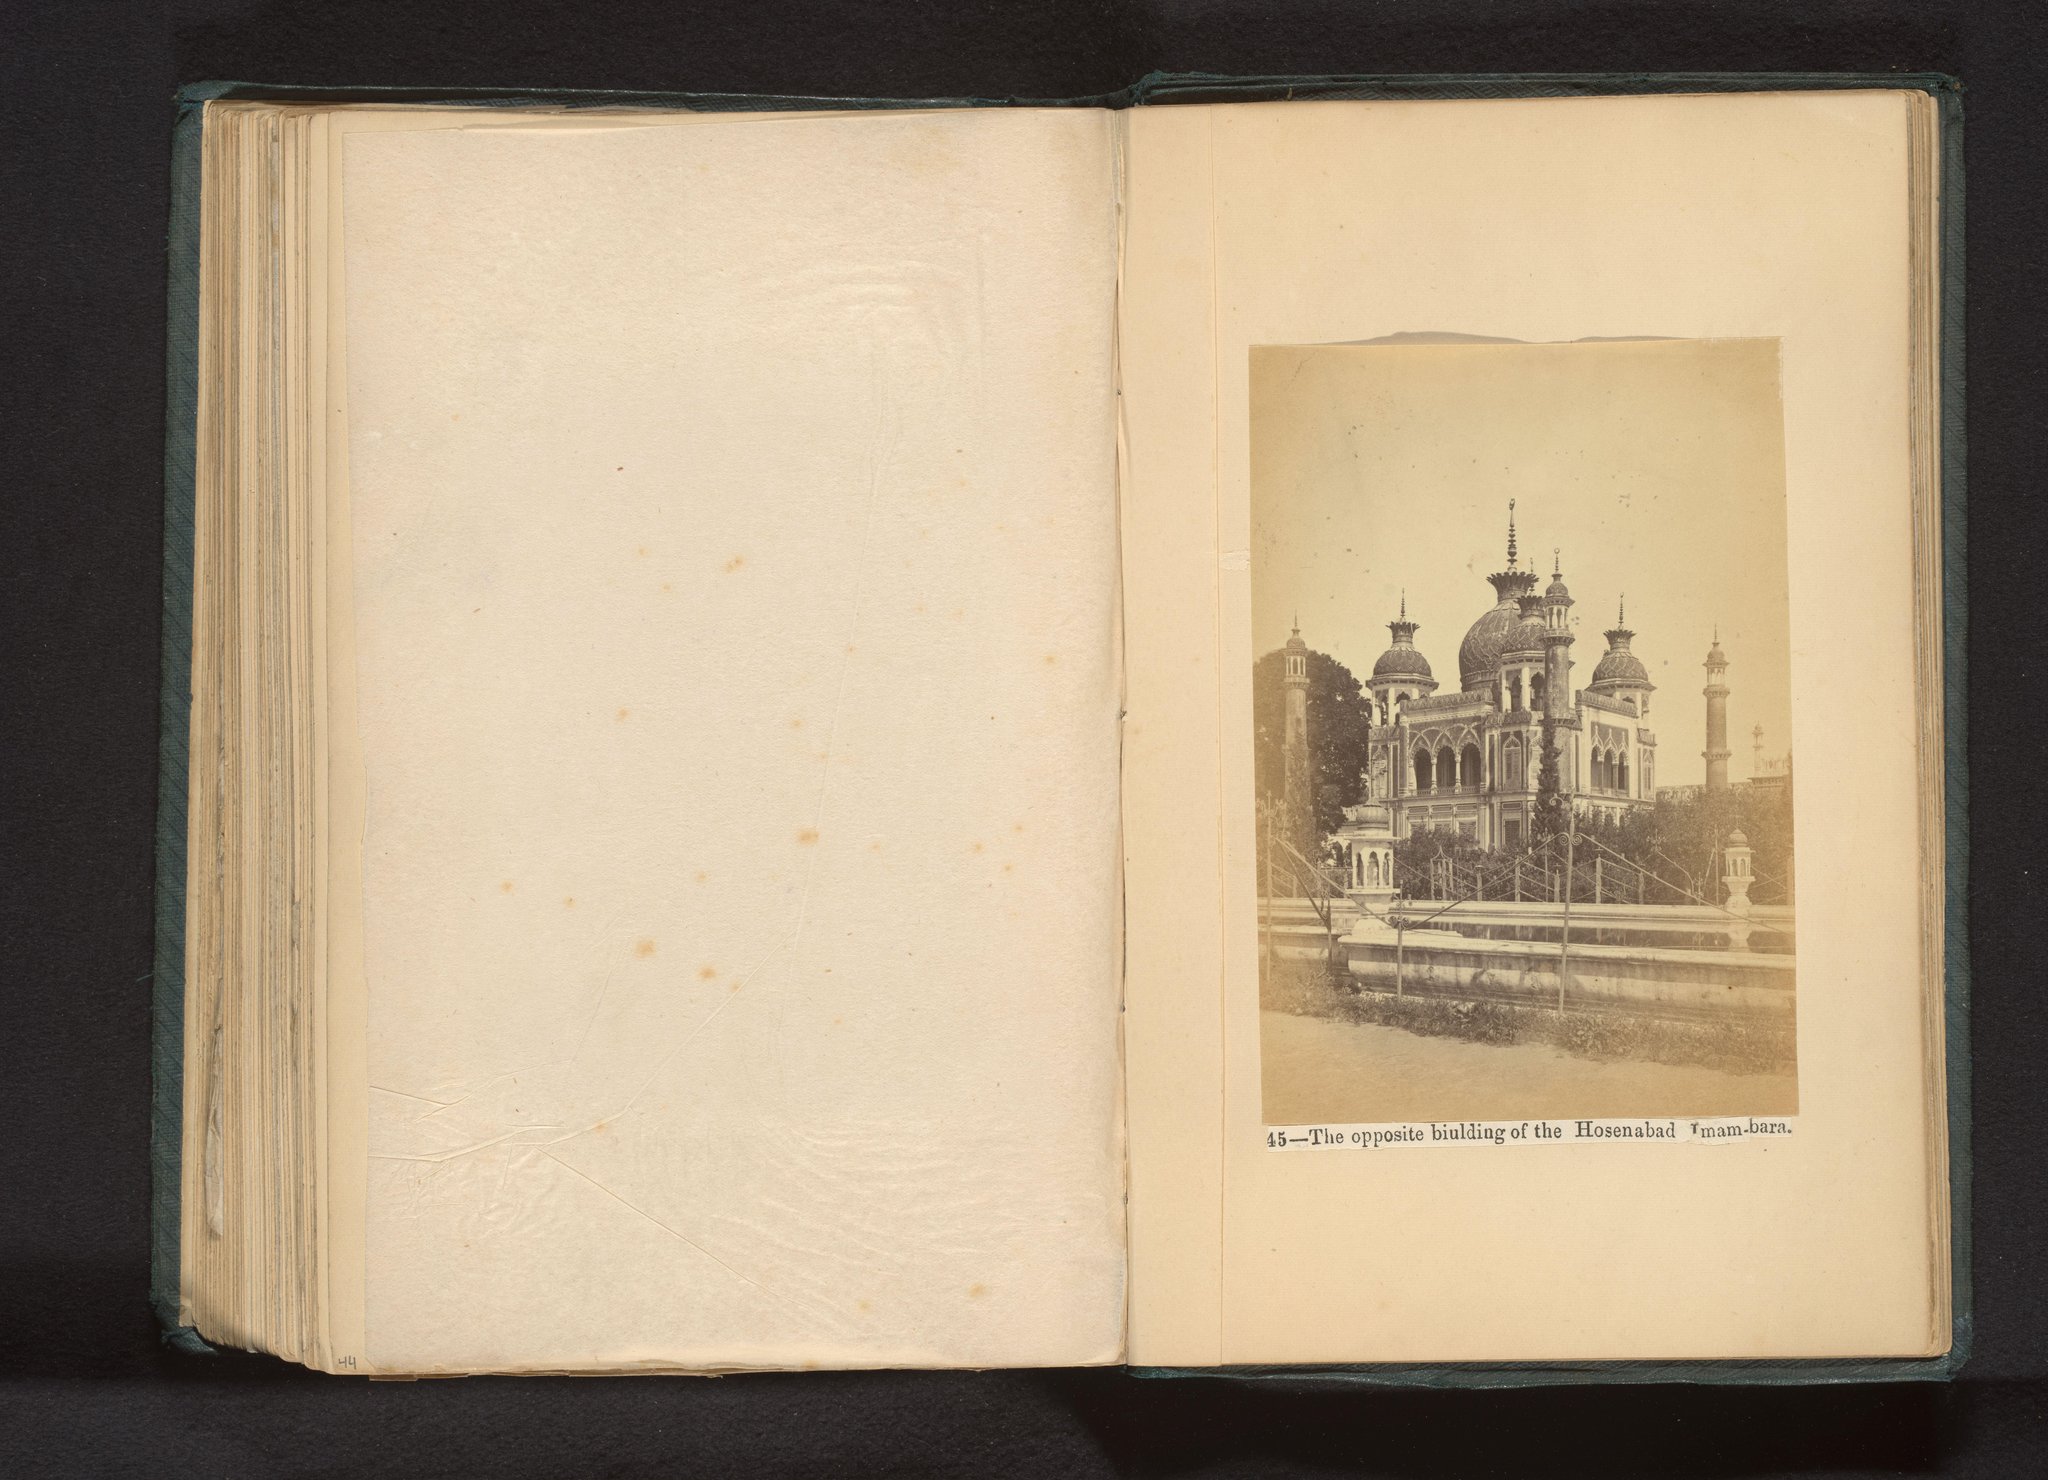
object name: page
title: Gezicht op de schatkamer van het Chota Imambara in Lucknow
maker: darogha ubbas alli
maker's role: fotograaf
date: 1864-1874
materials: photographic support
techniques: albumen print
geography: lucknow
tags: temple, shrine ~ islam, mohammedanism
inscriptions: number: ‘45’